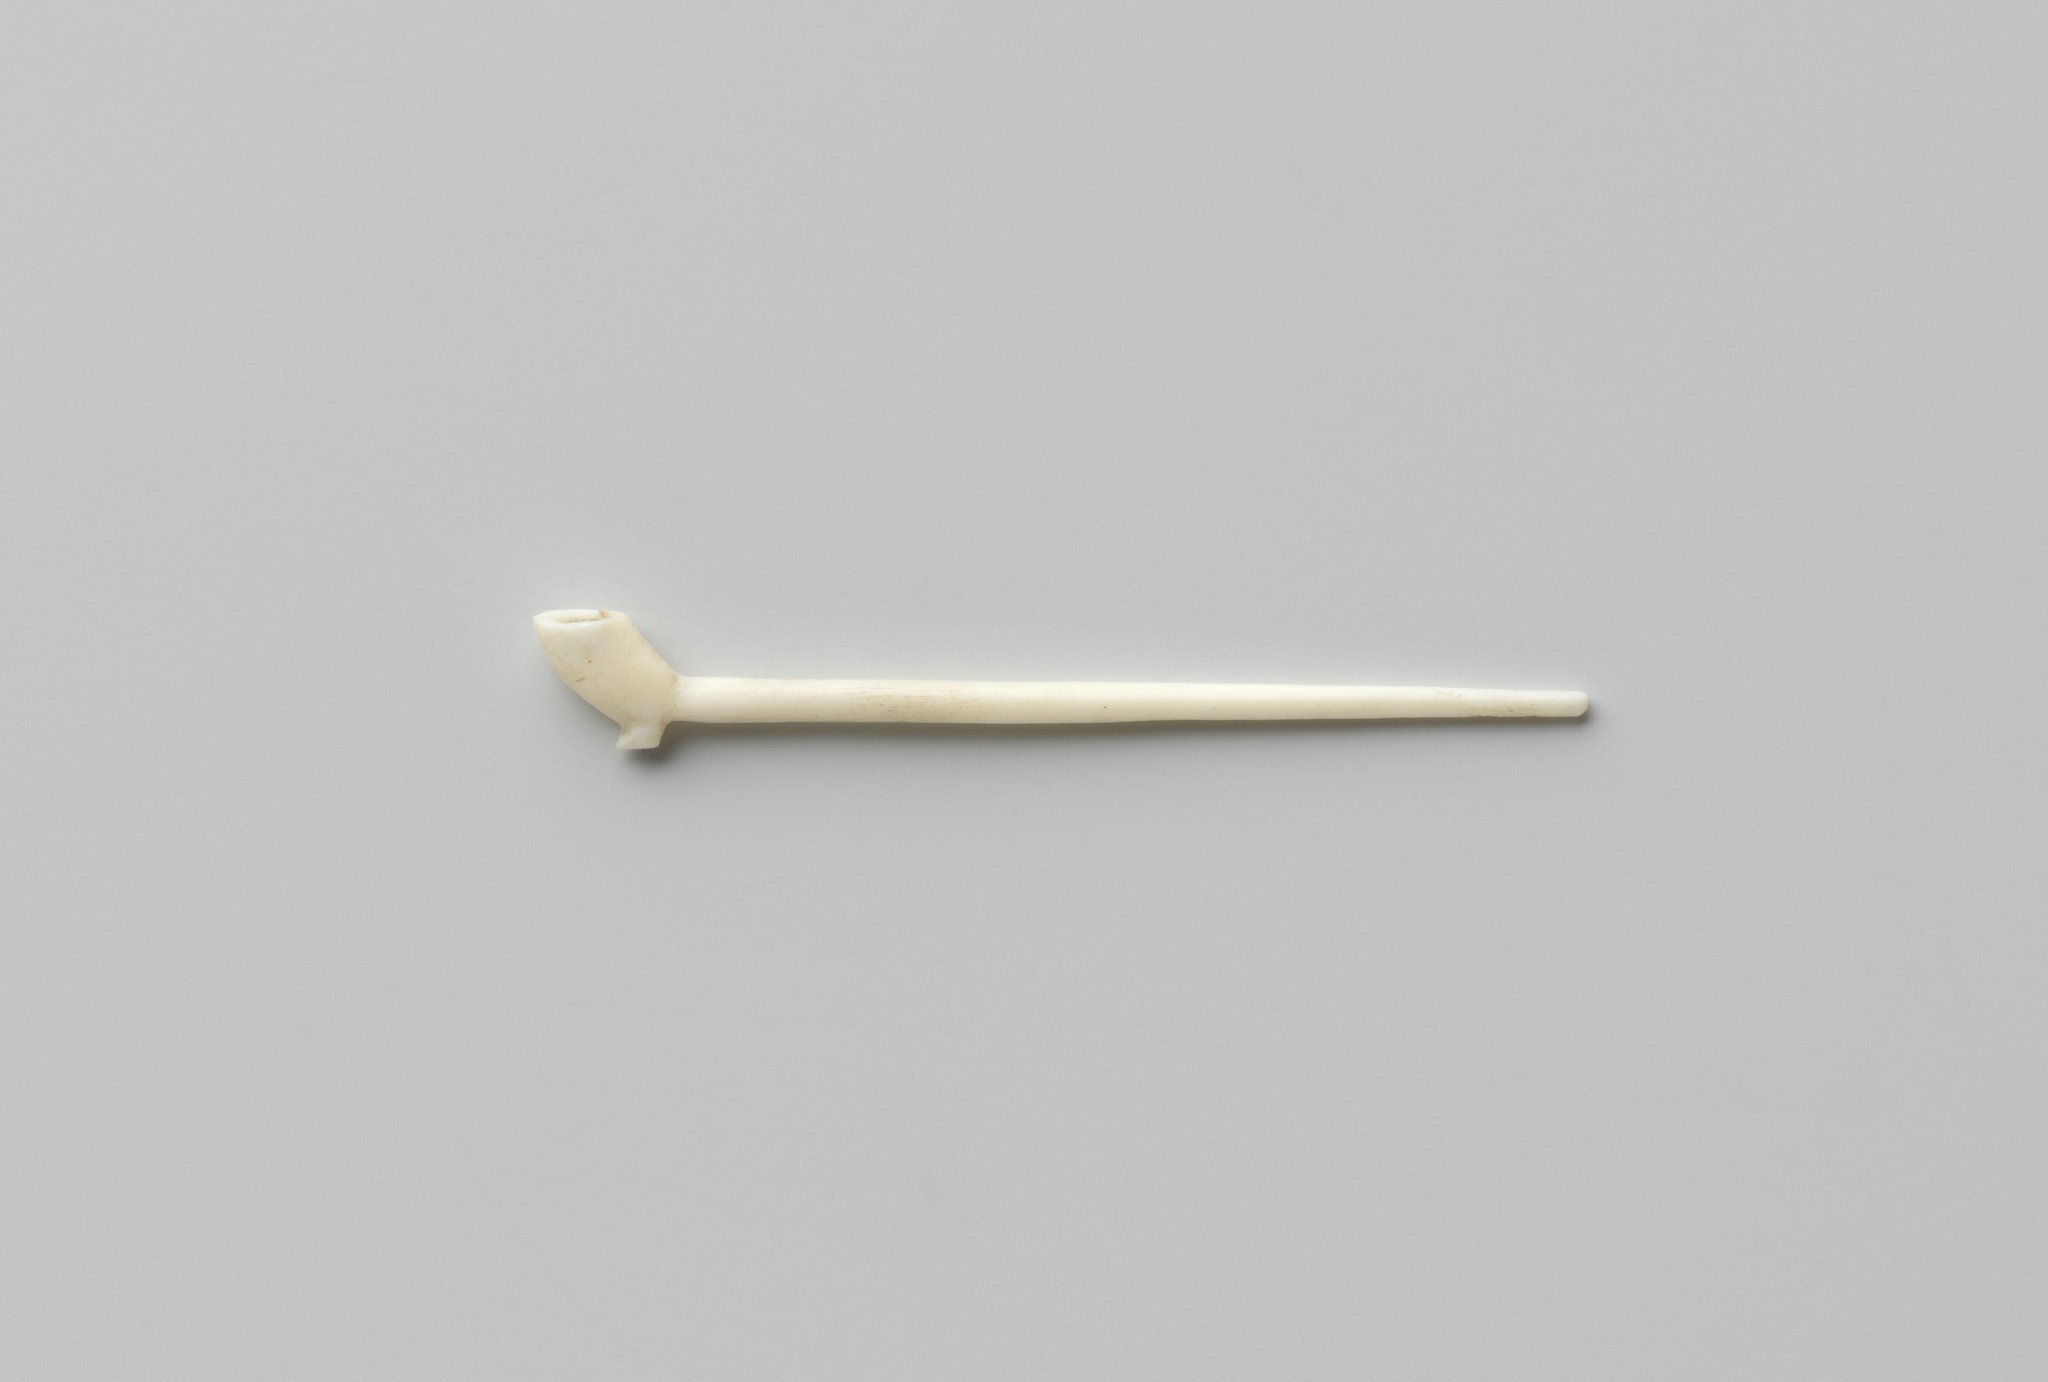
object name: miniature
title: Pijp, model 'Goudse' pijp met lange steel en kop met hiel, vervaardigd van been.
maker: Anonymous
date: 1690-1710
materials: bone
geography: amsterdam